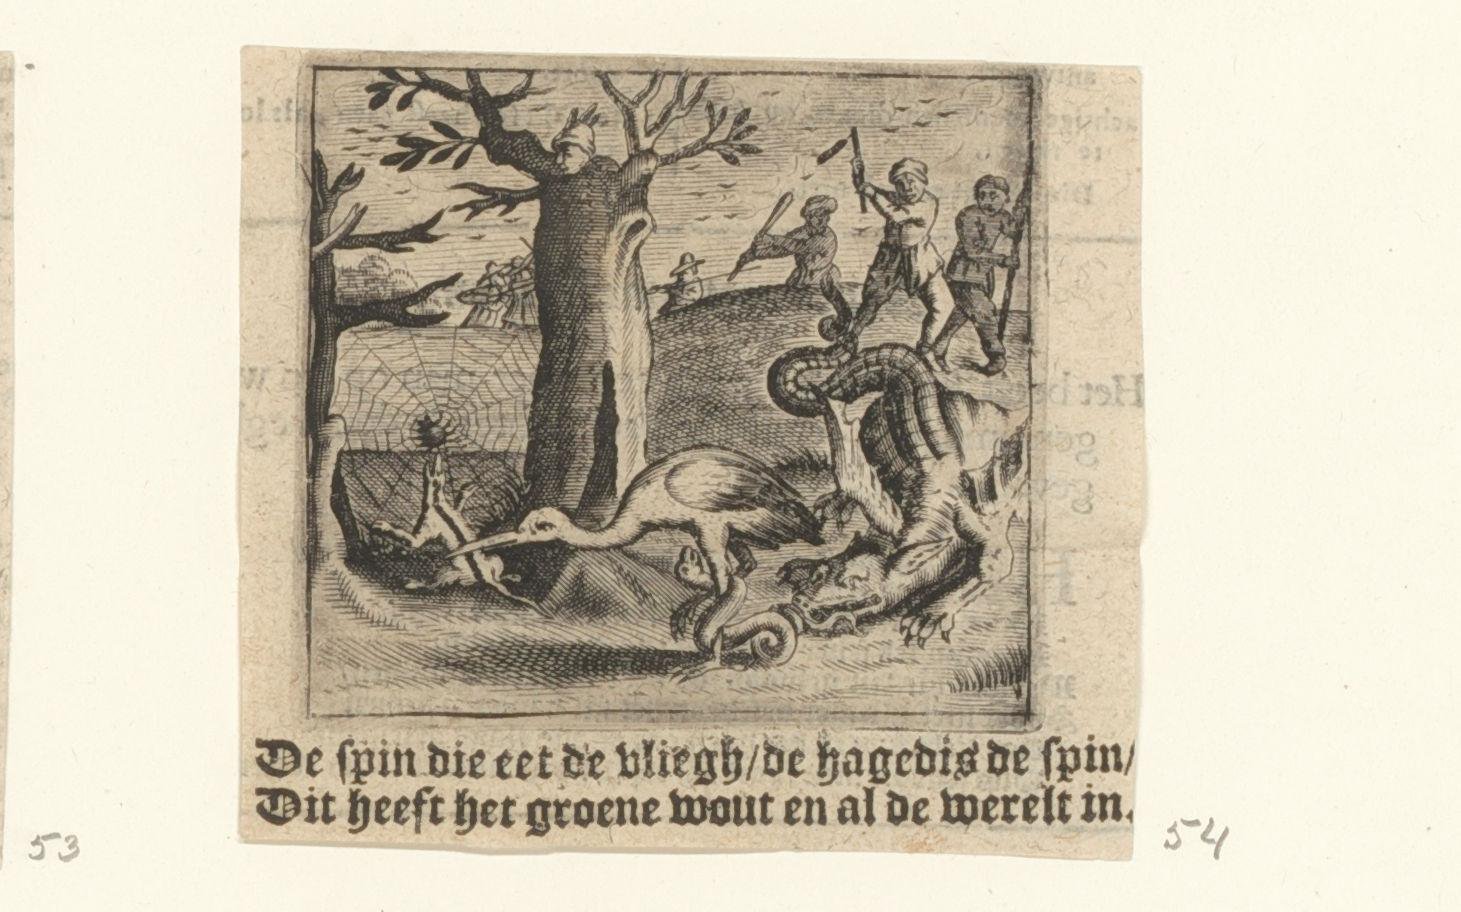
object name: print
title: De spin die eet de vliegh / de hagedis de spin / Dit heeft het groene wout en al de werelt in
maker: Anonymous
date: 1635-1715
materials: paper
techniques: engraving, letterpress printing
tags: birds, lizards: lizard, proverbs, sayings, etc., spiders, insects: fly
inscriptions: stamp, collector's mark: Lugt 1641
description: Veel versies van dit embleem verschenen in verschillende uitgave van Spiegel van den Ouden ende Nieuwen Tydt. Zoals: Cats, Jacob. Spiegel van den Ouden ende Nieuwen-tijt, Bestaende uyt Spreeck-woorden (...). Dordrecht: Jacob Braat, 1647. Maar ook in andere publicaties (1665, 1671, 1715, 1722).